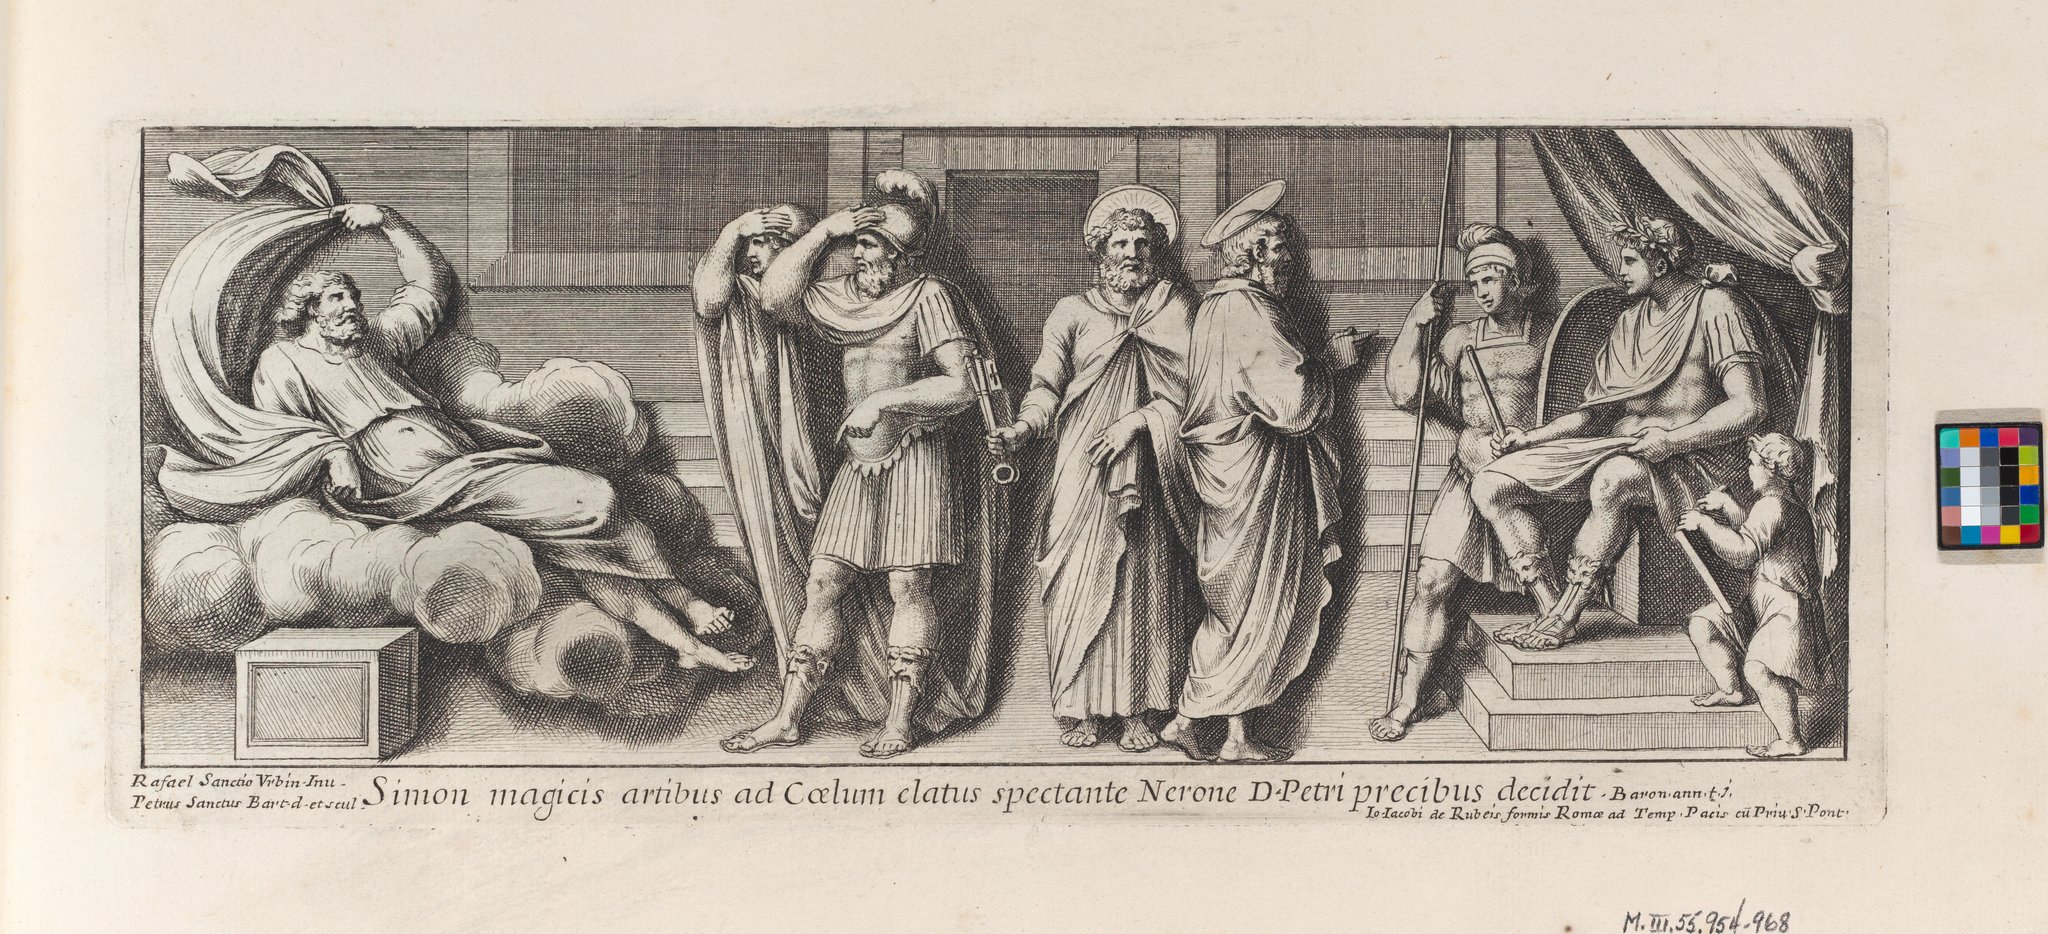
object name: print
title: Saint Paul standing before the Proconsul, from a series of 15 plates, depicting Raphael's works for the Vatican stanze and the Sistine Chapel tapestries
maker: pietro santi bartoli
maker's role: artist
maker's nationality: italian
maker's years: 1615-1700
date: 1650-1670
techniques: etching